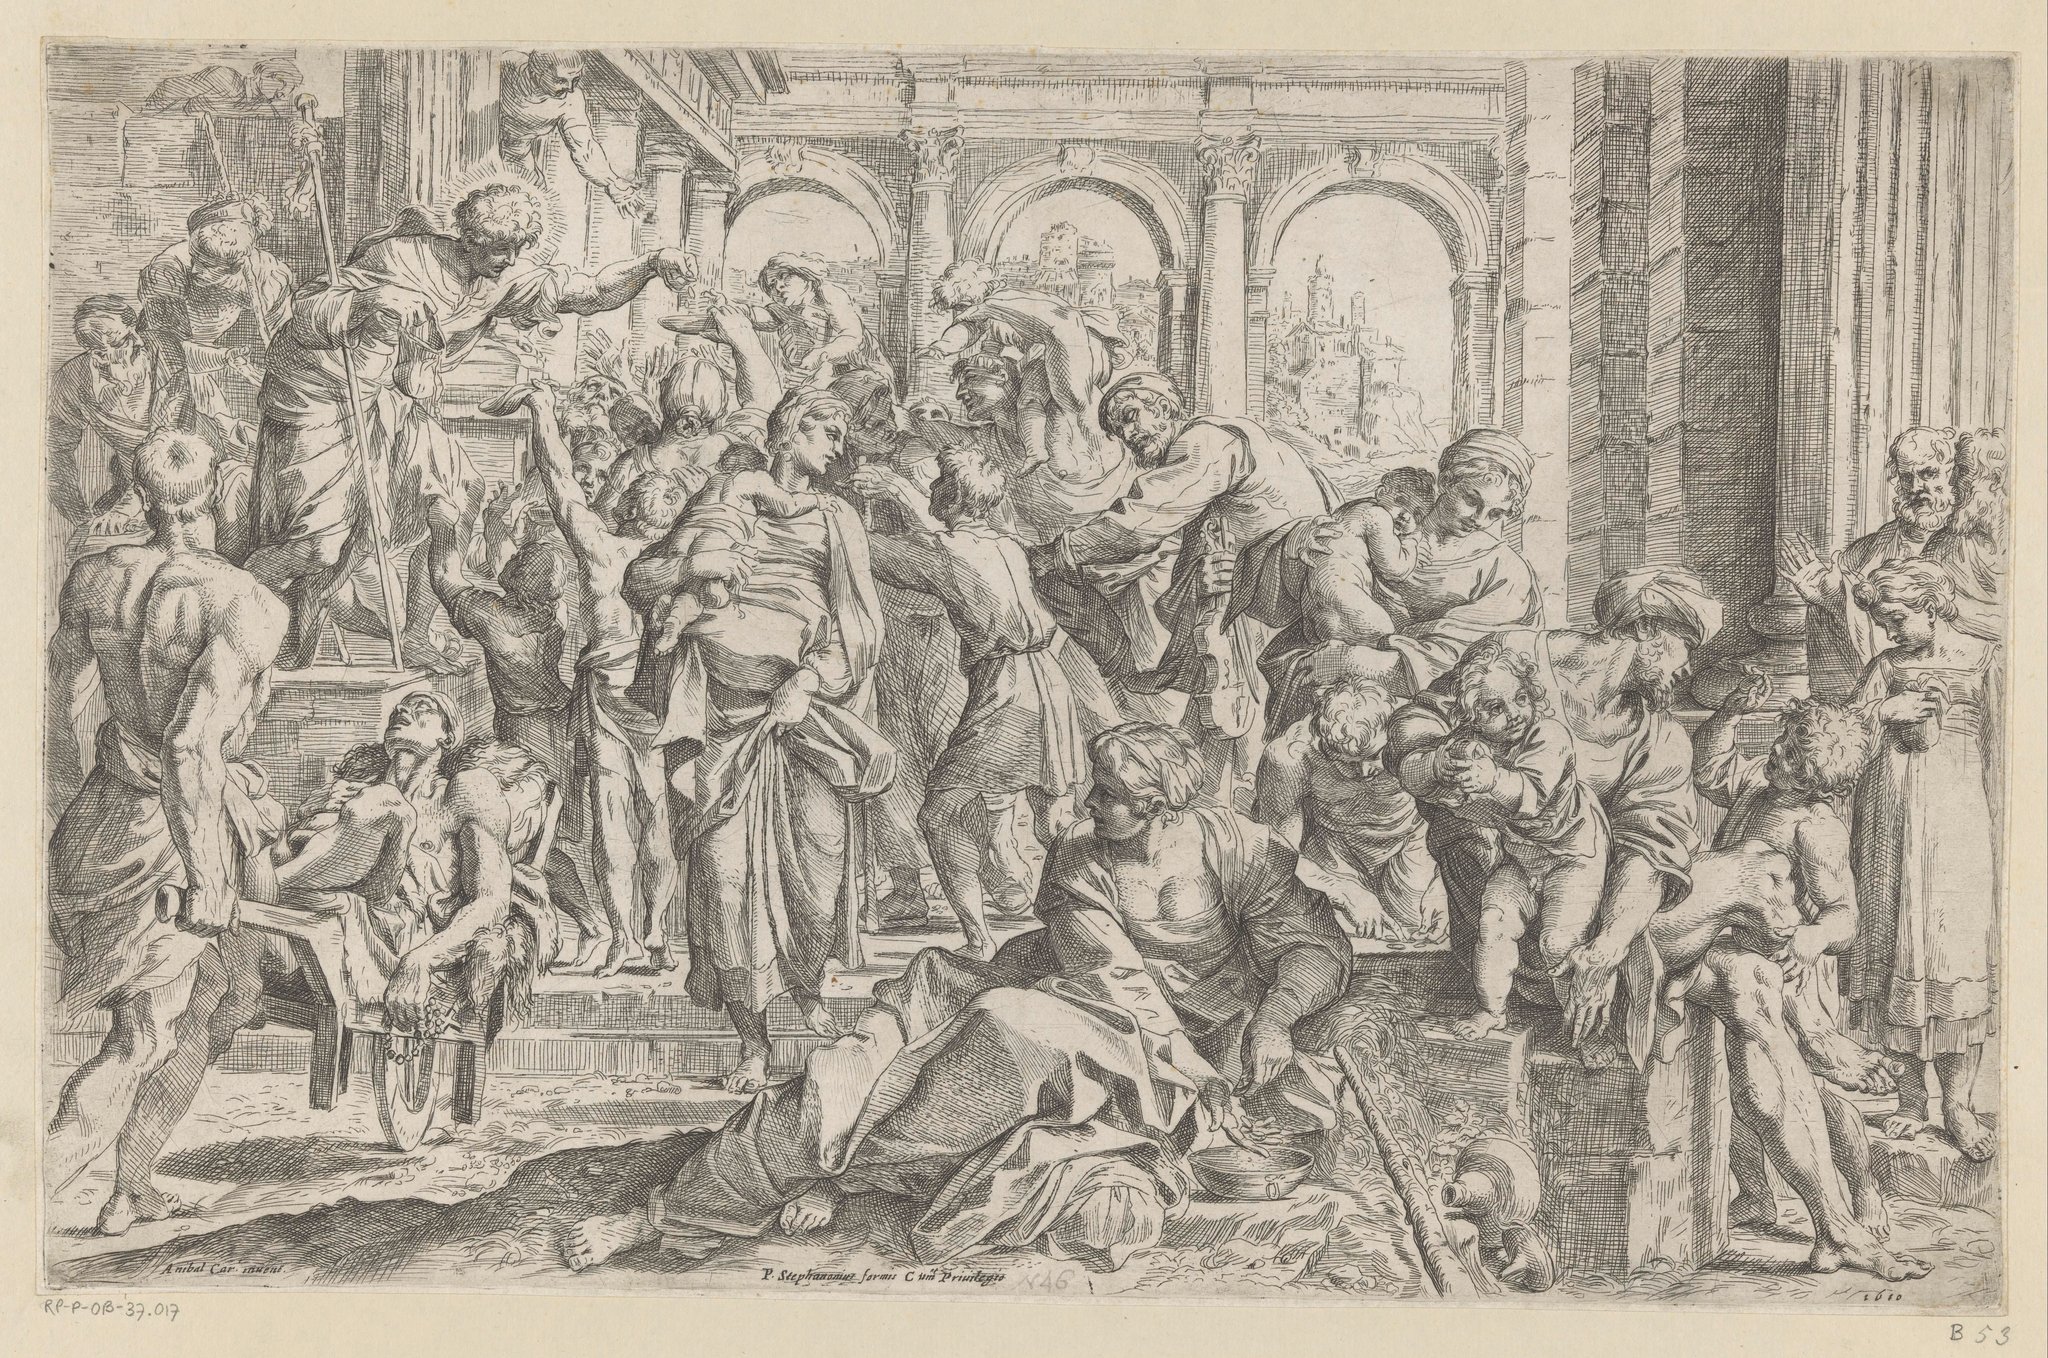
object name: print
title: De heilige Rochus deelt aalmoezen uit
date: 1610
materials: paper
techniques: etching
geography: italy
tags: st. roch distributes his riches to the poor, and leaves on a pilgrimage, blind, blindness, disabilities, deformations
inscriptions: collector's mark: Lugt 240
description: Gezicht in een bouwwerk met zuilen en ronde bogen. Op een verhoging links staat de heilige Rochus aalmoezen uit te delen aan een menigte bedelende mannen, vrouwen en kinderen, waarvan sommige beperkingen hebben.